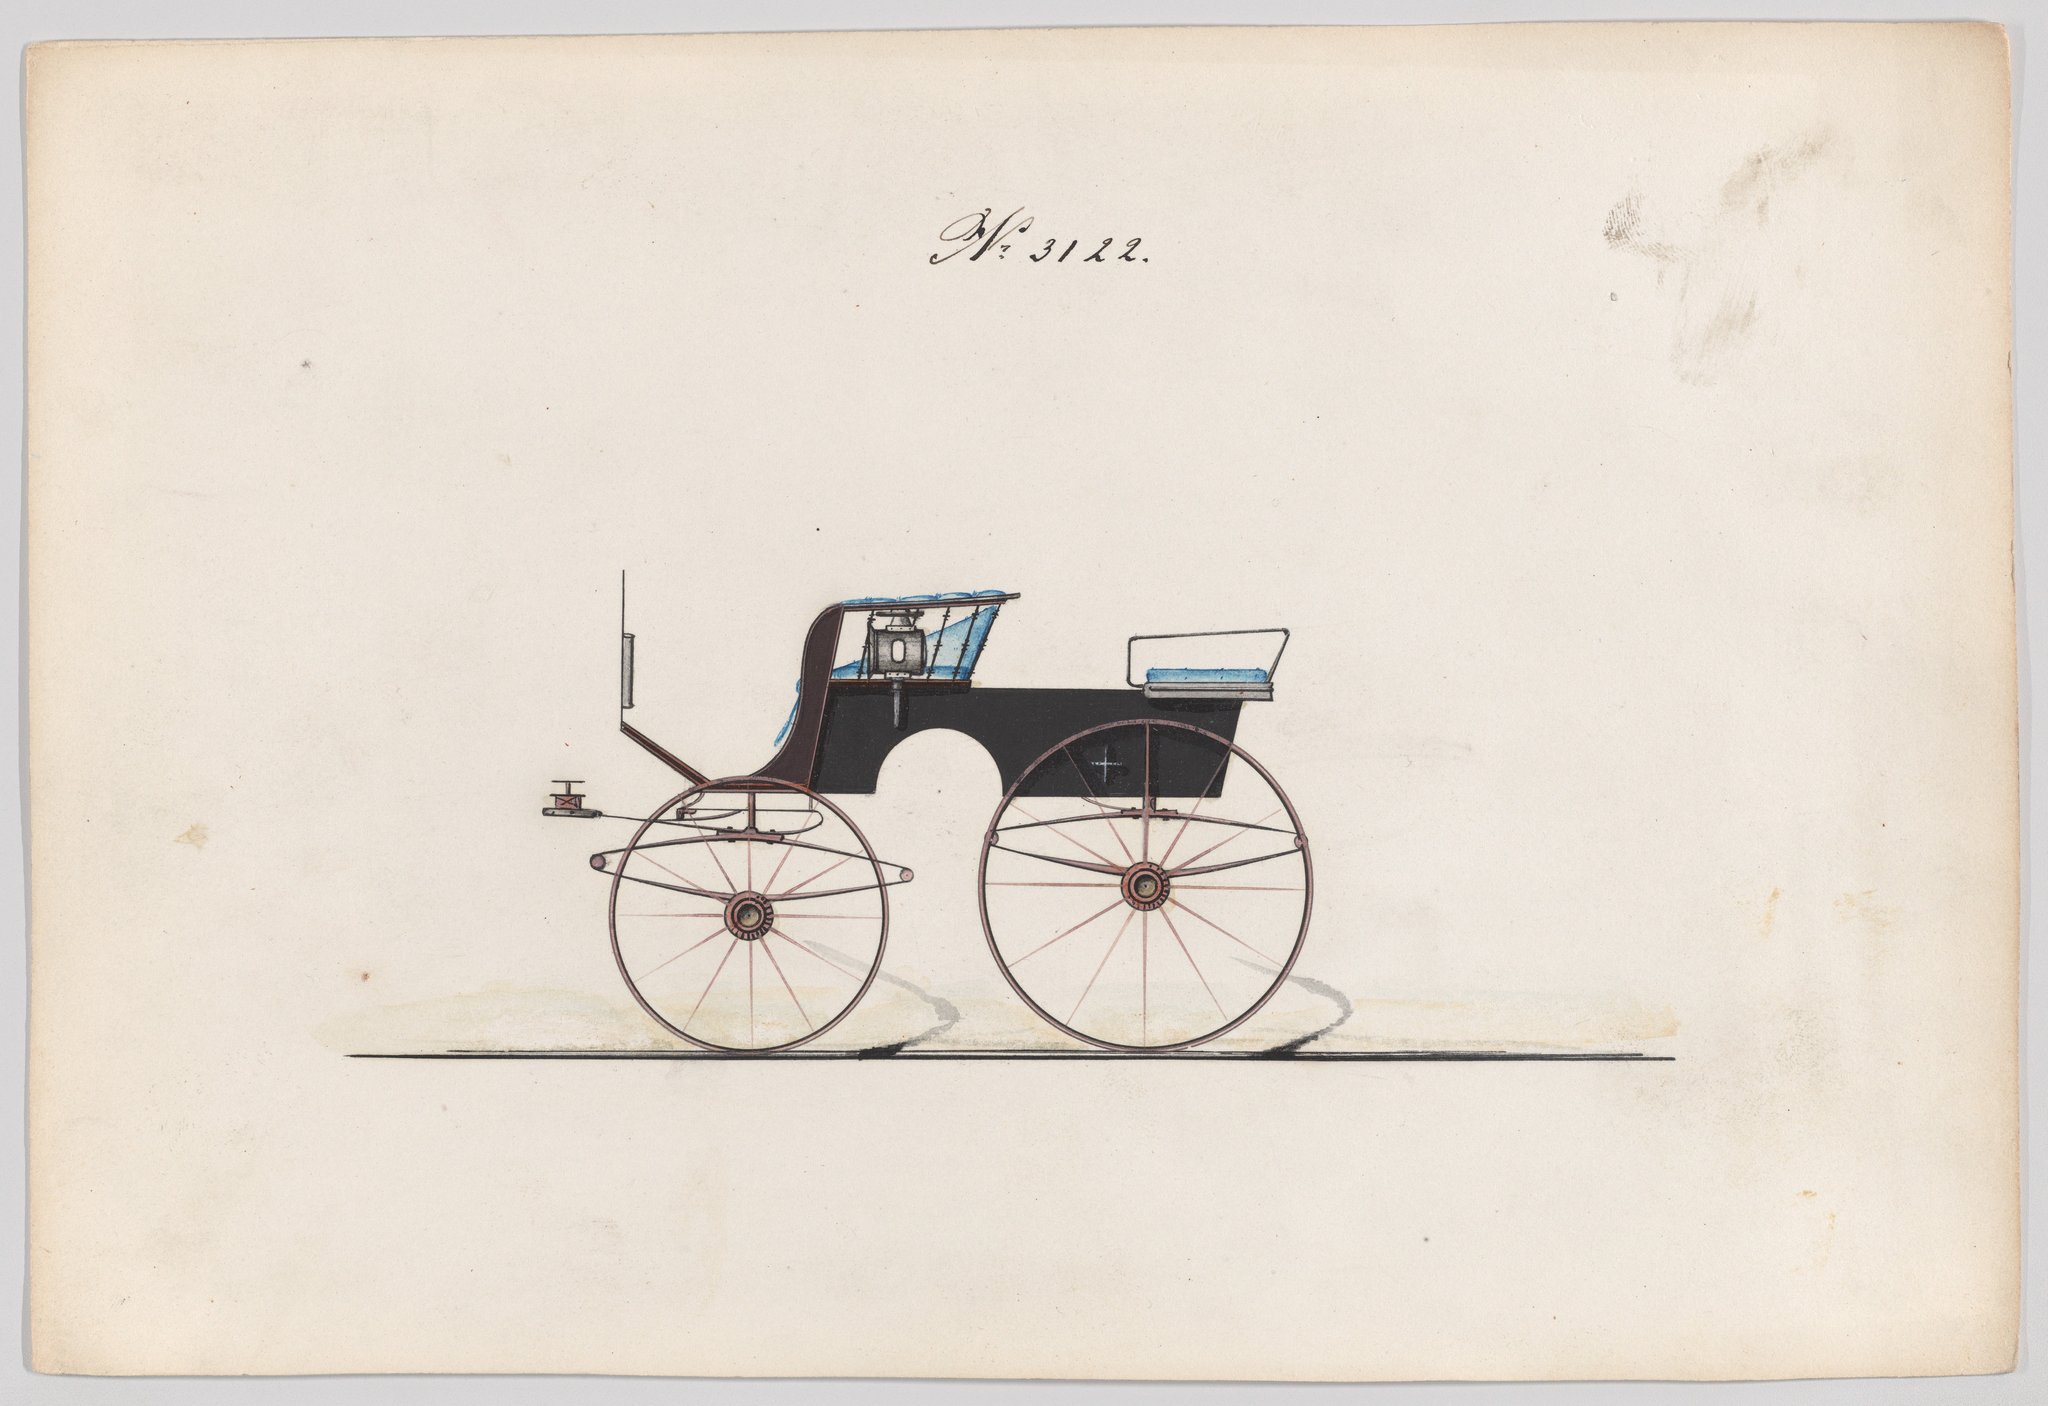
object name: drawing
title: Design for T-Cart, no. 3122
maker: brewster & co.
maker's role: manufacturer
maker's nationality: american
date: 1875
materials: gum arabic, ink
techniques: pen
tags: carriages